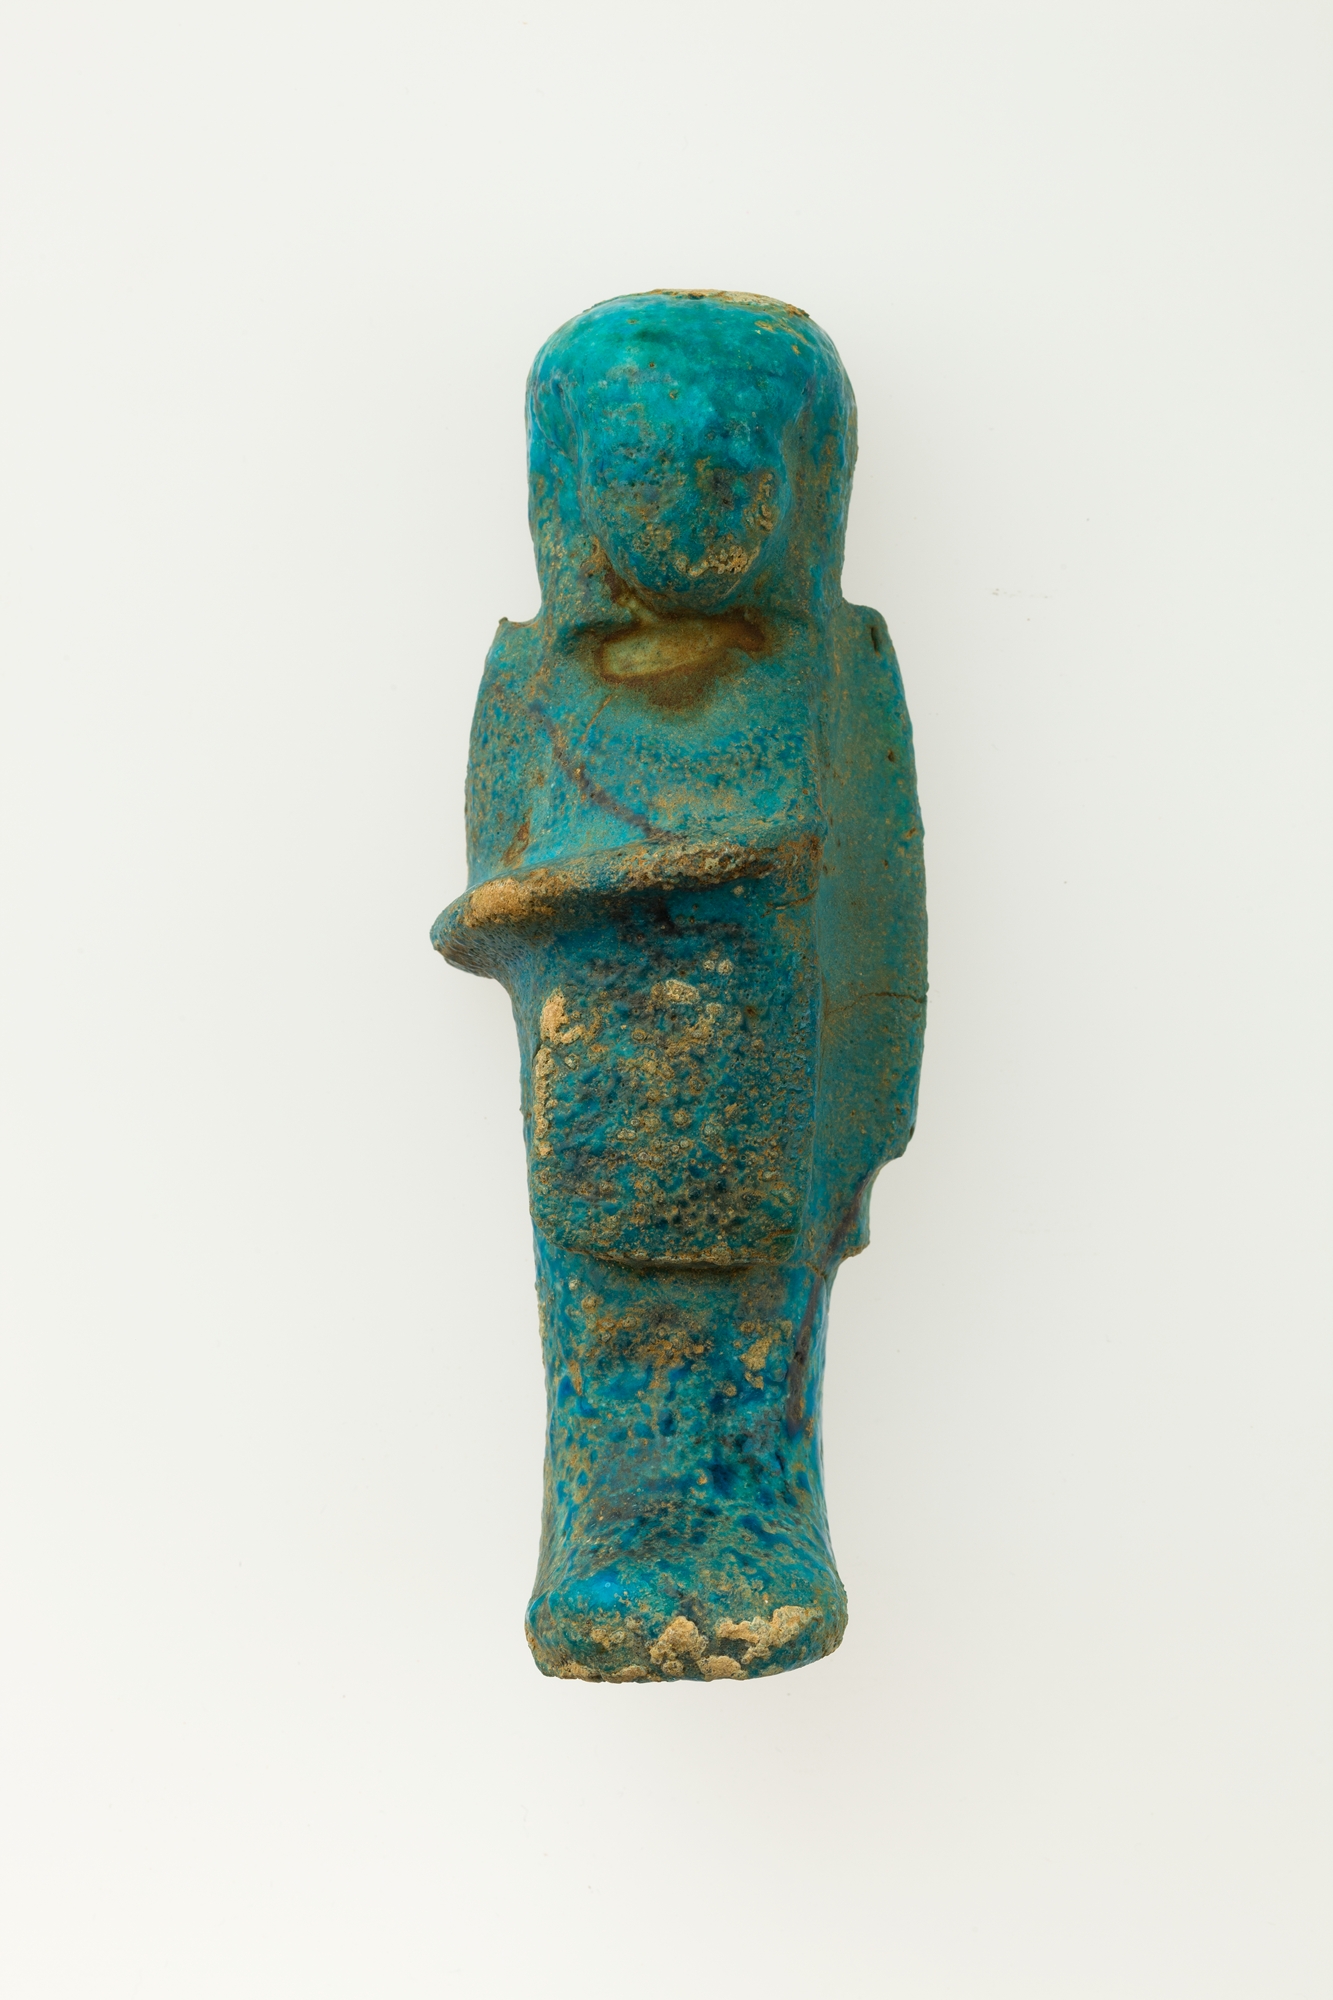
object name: shabti, henettawy c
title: Overseer Shabti of Henettawy (C), Daughter of Isetemkheb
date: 990-970 BCE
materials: faience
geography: egypt